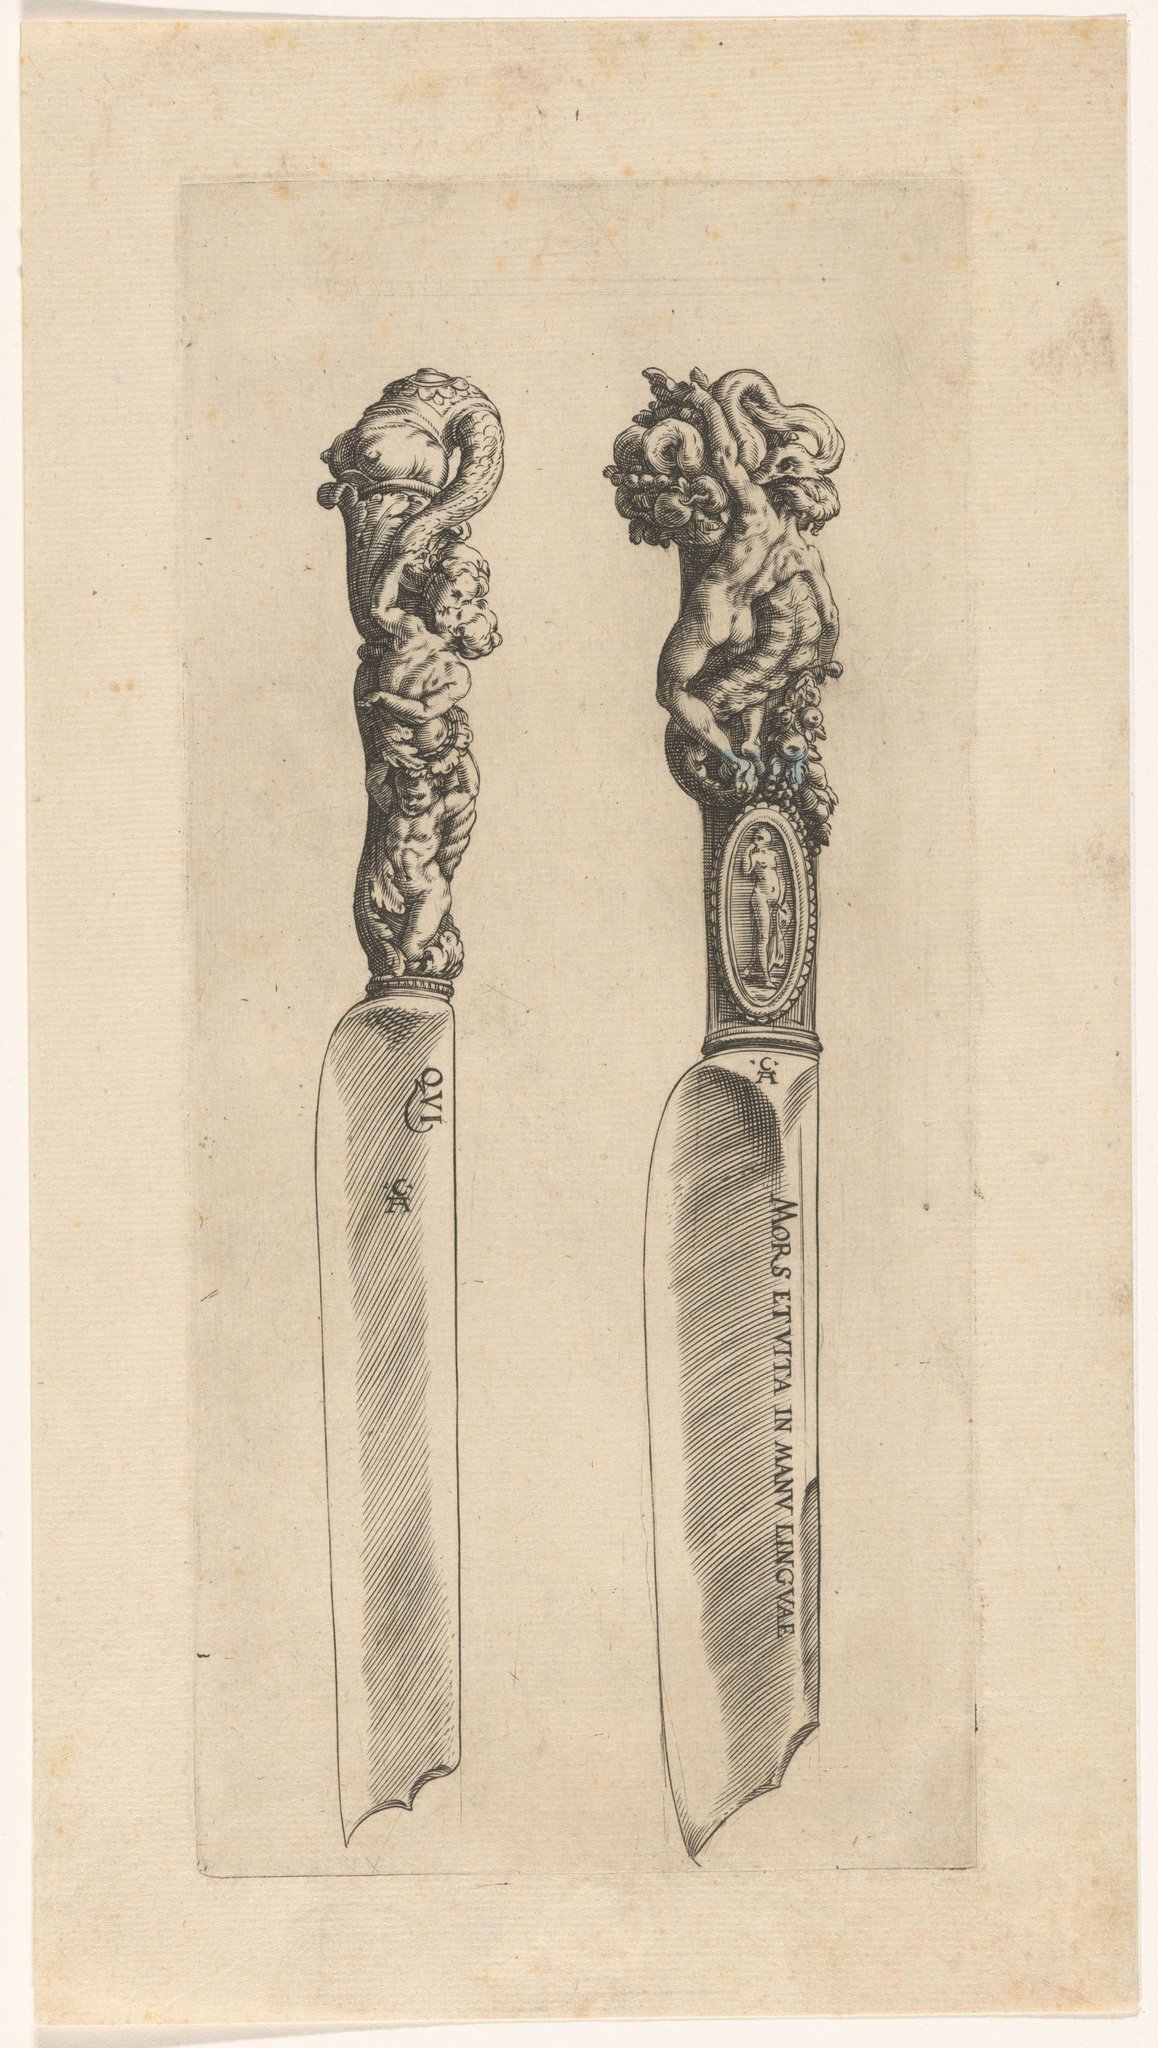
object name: print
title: Twee messen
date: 1583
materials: paper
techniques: engraving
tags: snakes, 'cornucopia', horn of plenty, ornaments ~ art, tools, aids, implements ~ crafts and industries: knife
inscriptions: collector's mark: Lugt 5k, monogram: ‘C/A’, collector's mark: Lugt 2228, collector's mark: Lugt 2760, monogram: ‘C/A’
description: Het heft van het linker mes is gedecoreerd met een vrouw en een kind. Het mes wordt bekroond door de buste van een vrouwelijk wezen met een lange geschubde hals. Dit wezen buigt zich naar beneden en kust de vrouw onder haar. Het heft van het rechter mes wordt bekroond door een man, op de rug gezien, die hangt aan een hoorn des overvloeds. Uit de hoorn komt een slang.